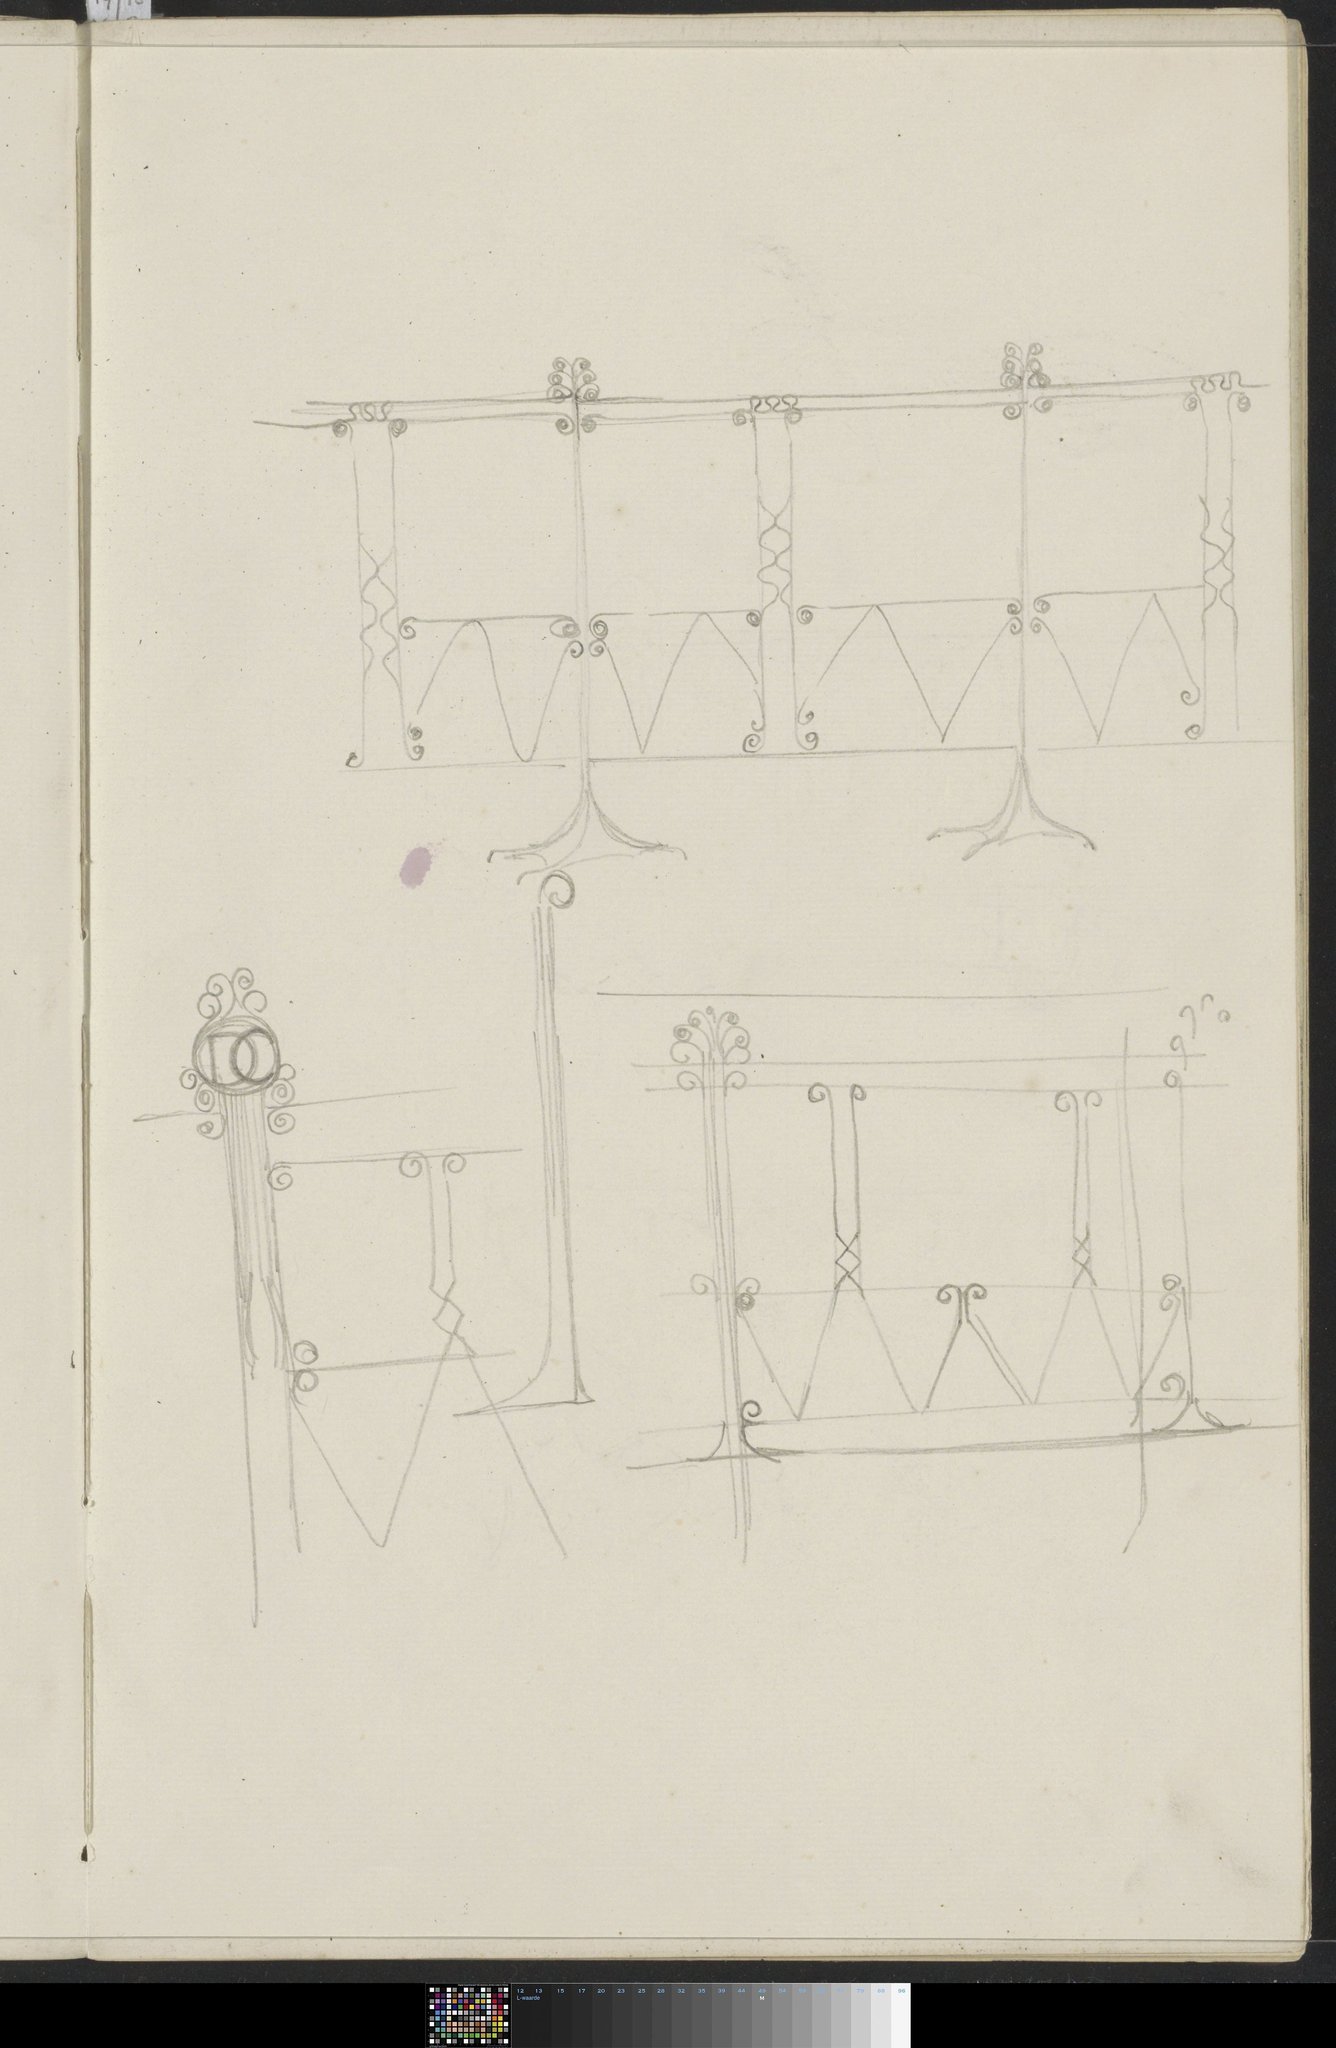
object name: sketchbook leaf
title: Ornamentontwerpen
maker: carel adolph lion cachet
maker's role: draughtsman, print maker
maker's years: 1864-1945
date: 1897-1898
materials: paper, pencil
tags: ornaments ~ art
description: Blad 11 recto uit een schetsboek met 29 bladen.